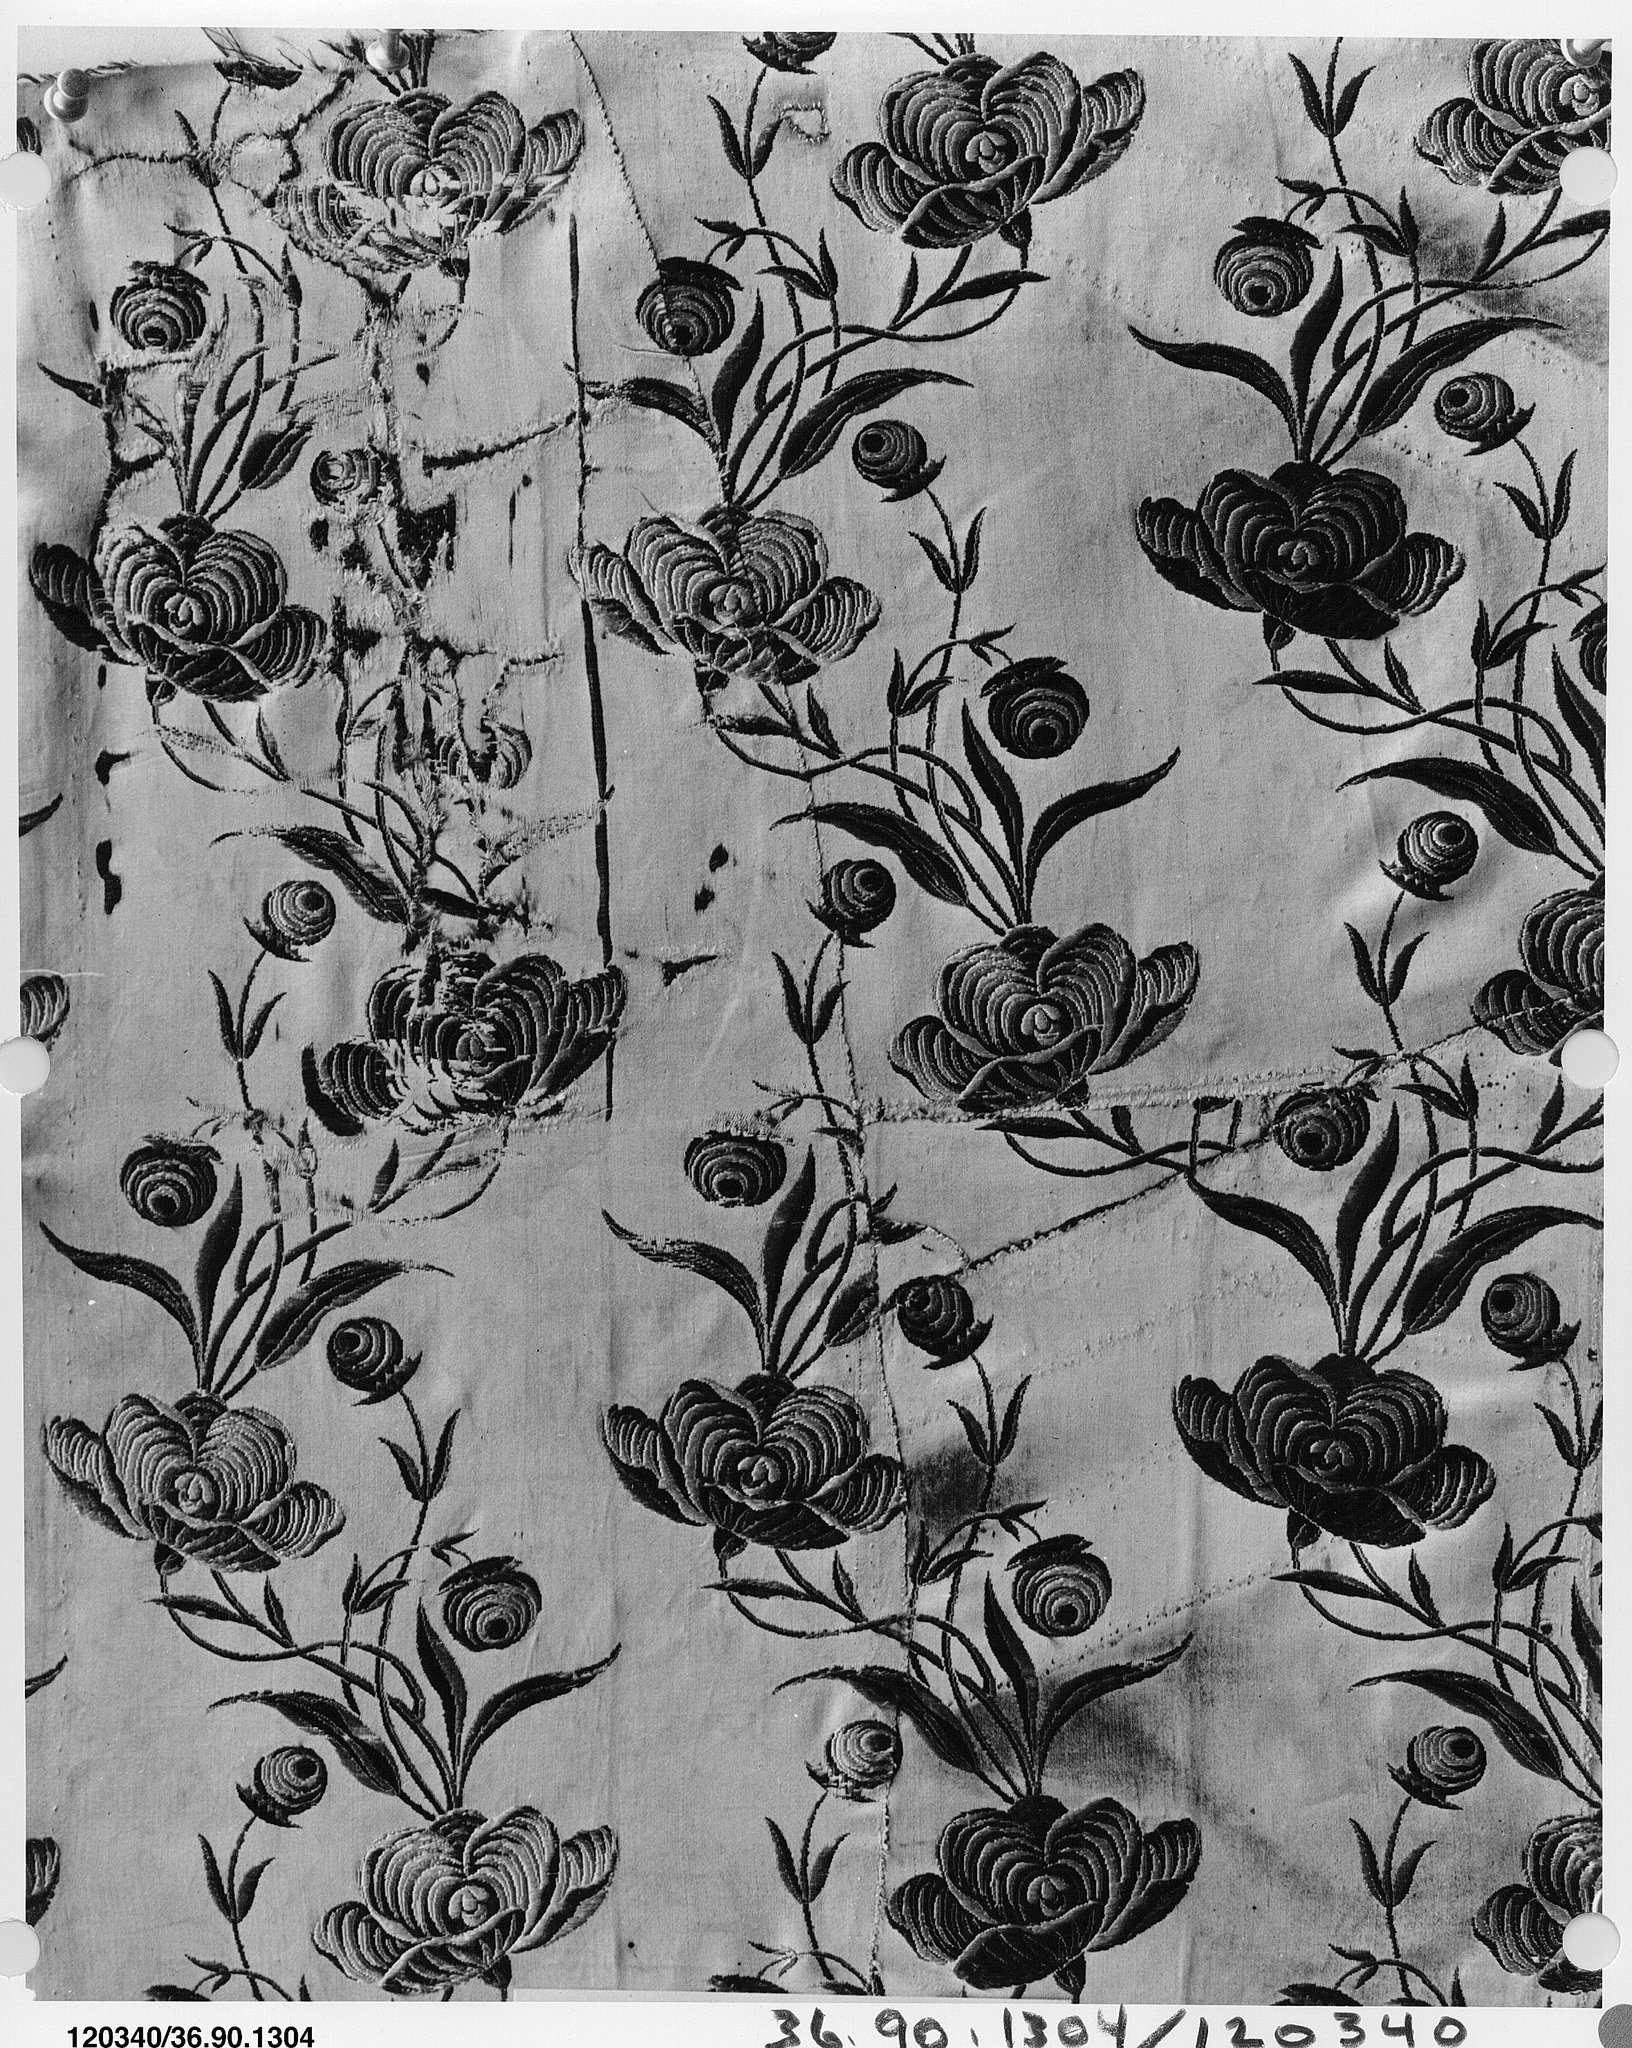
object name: piece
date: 1745-1750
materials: silk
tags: flowers,leaves